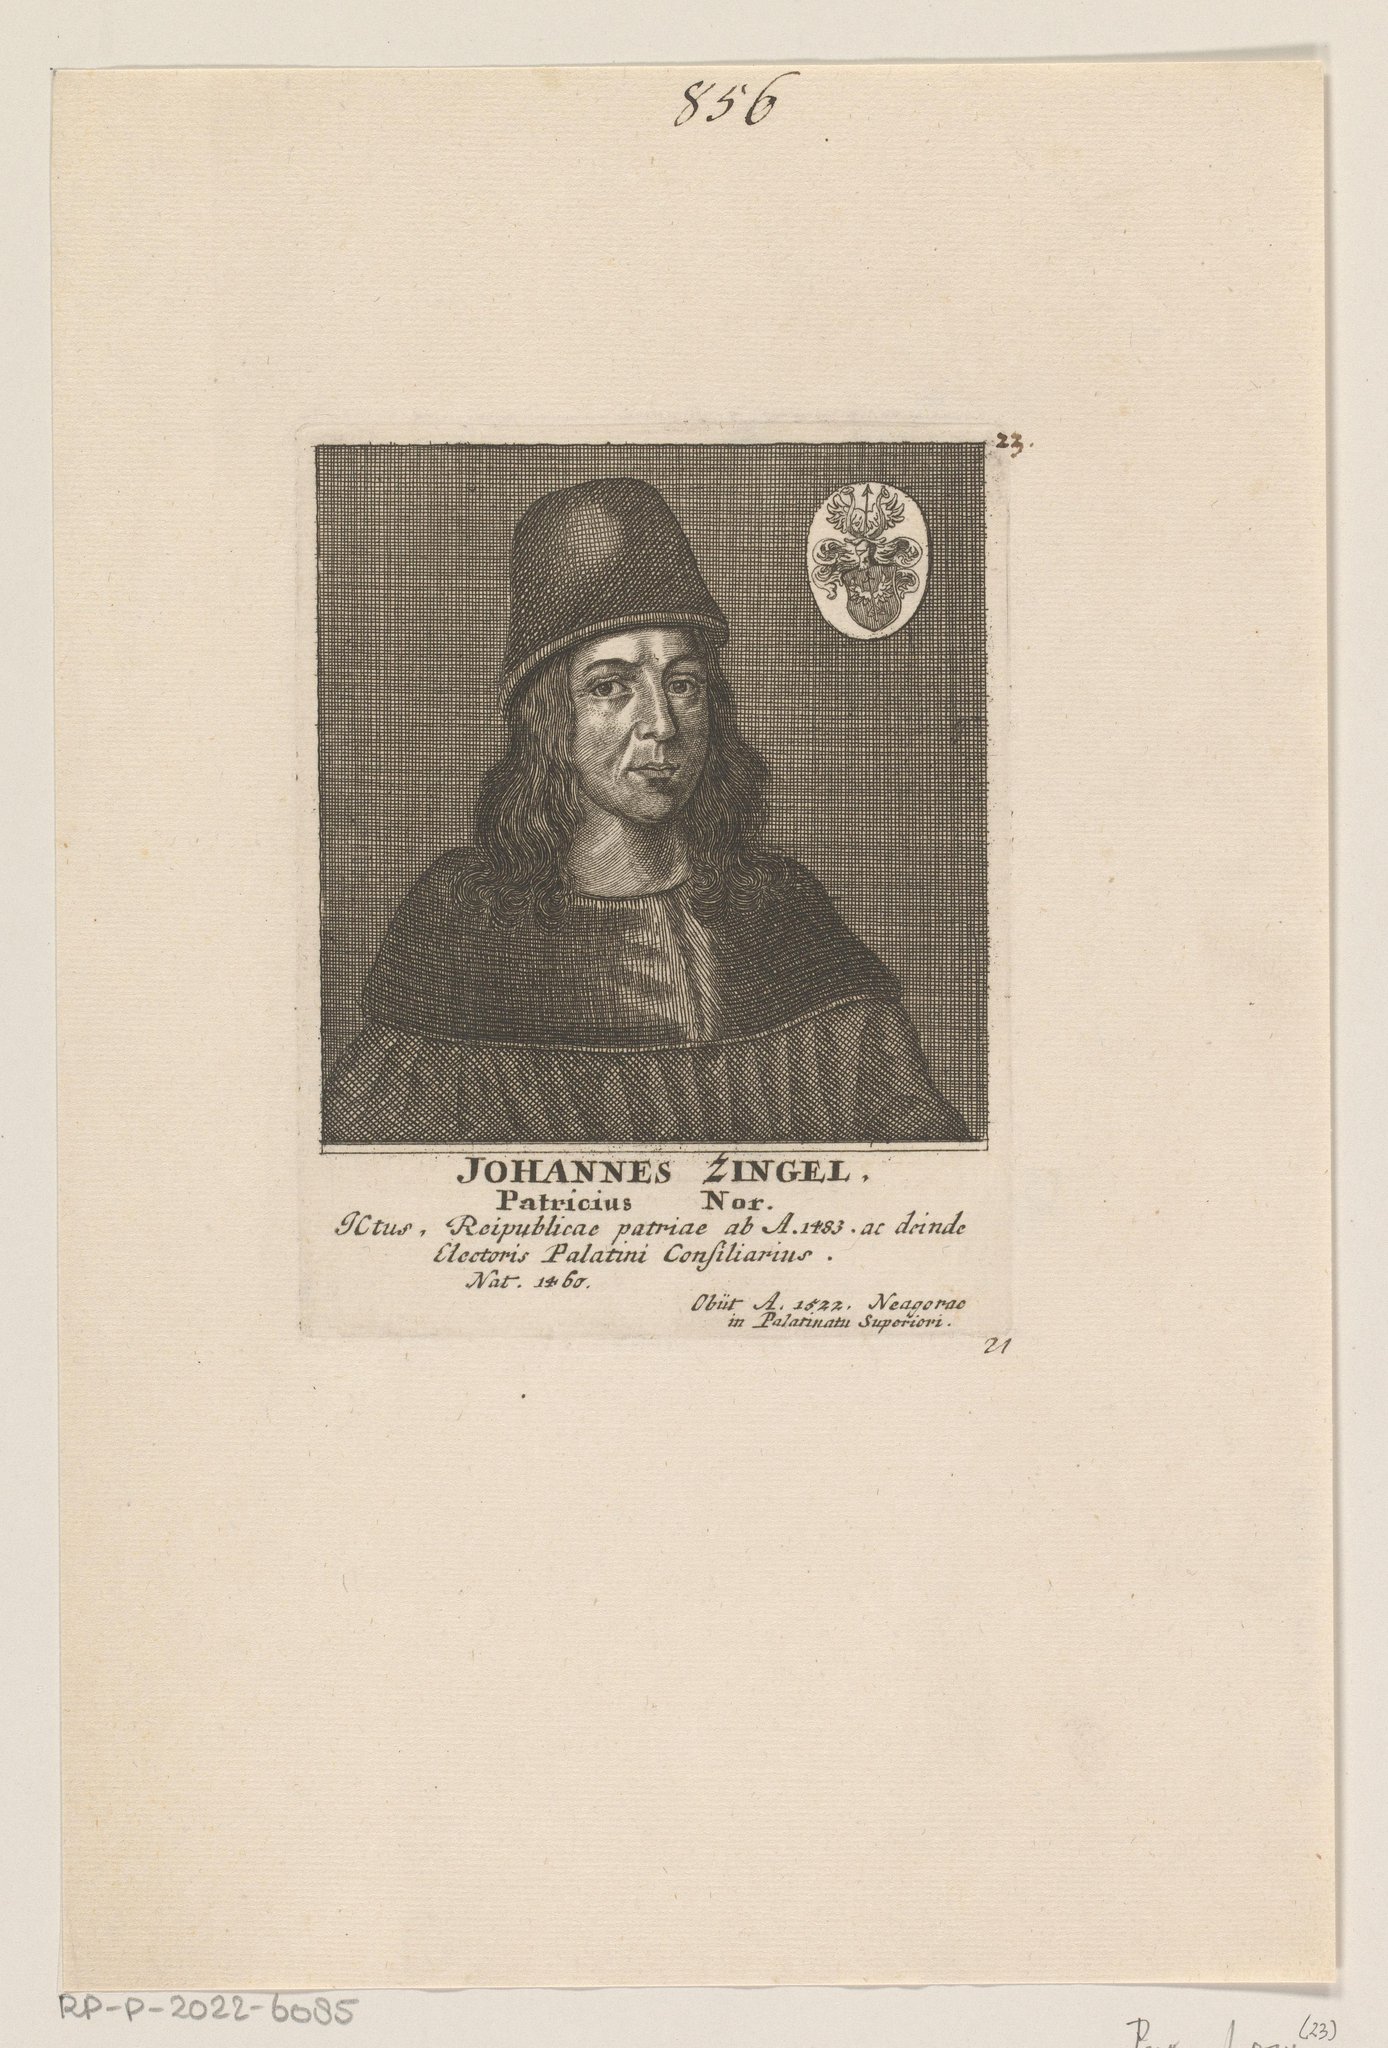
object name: print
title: Portret van Johann Zingel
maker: Anonymous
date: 1723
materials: paper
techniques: engraving, etching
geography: germany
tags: historical persons, armorial bearing, heraldry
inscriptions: number: ‘23.’, number: ‘856’, number: ‘21’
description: Prent waarschijnlijk uit: Rothscholtz, Friedrich. Icones consiliariorum de illustri republica Noribergensi (...). Neurenberg en Altdorf: erven Johann Daniel Tauber, 1723.